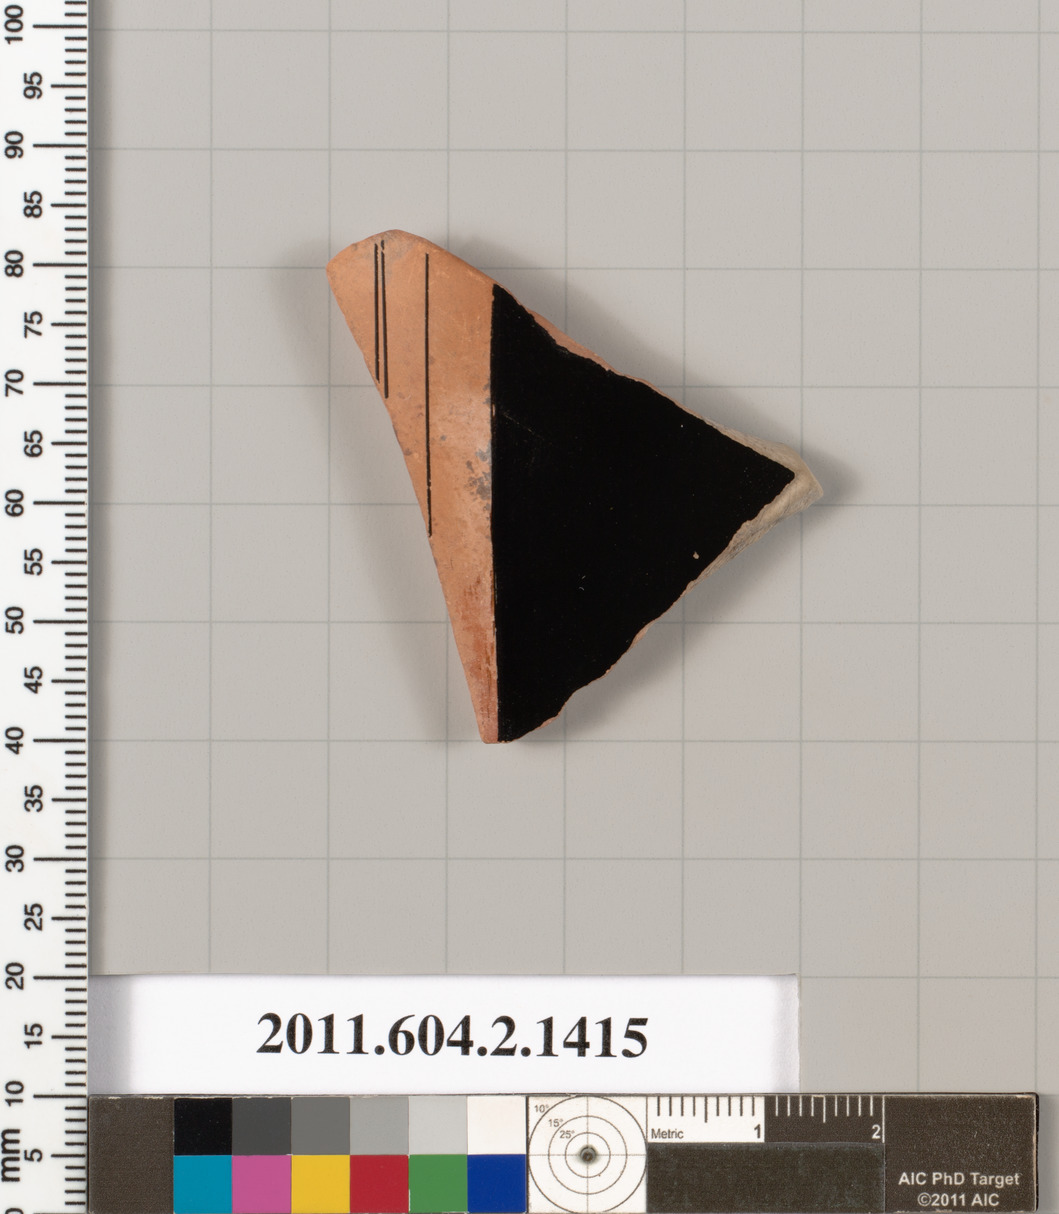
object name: skyphos fragment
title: Terracotta fragment of a skyphos (deep drinking cup)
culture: greek, attic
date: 467-435 BCE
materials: terracotta